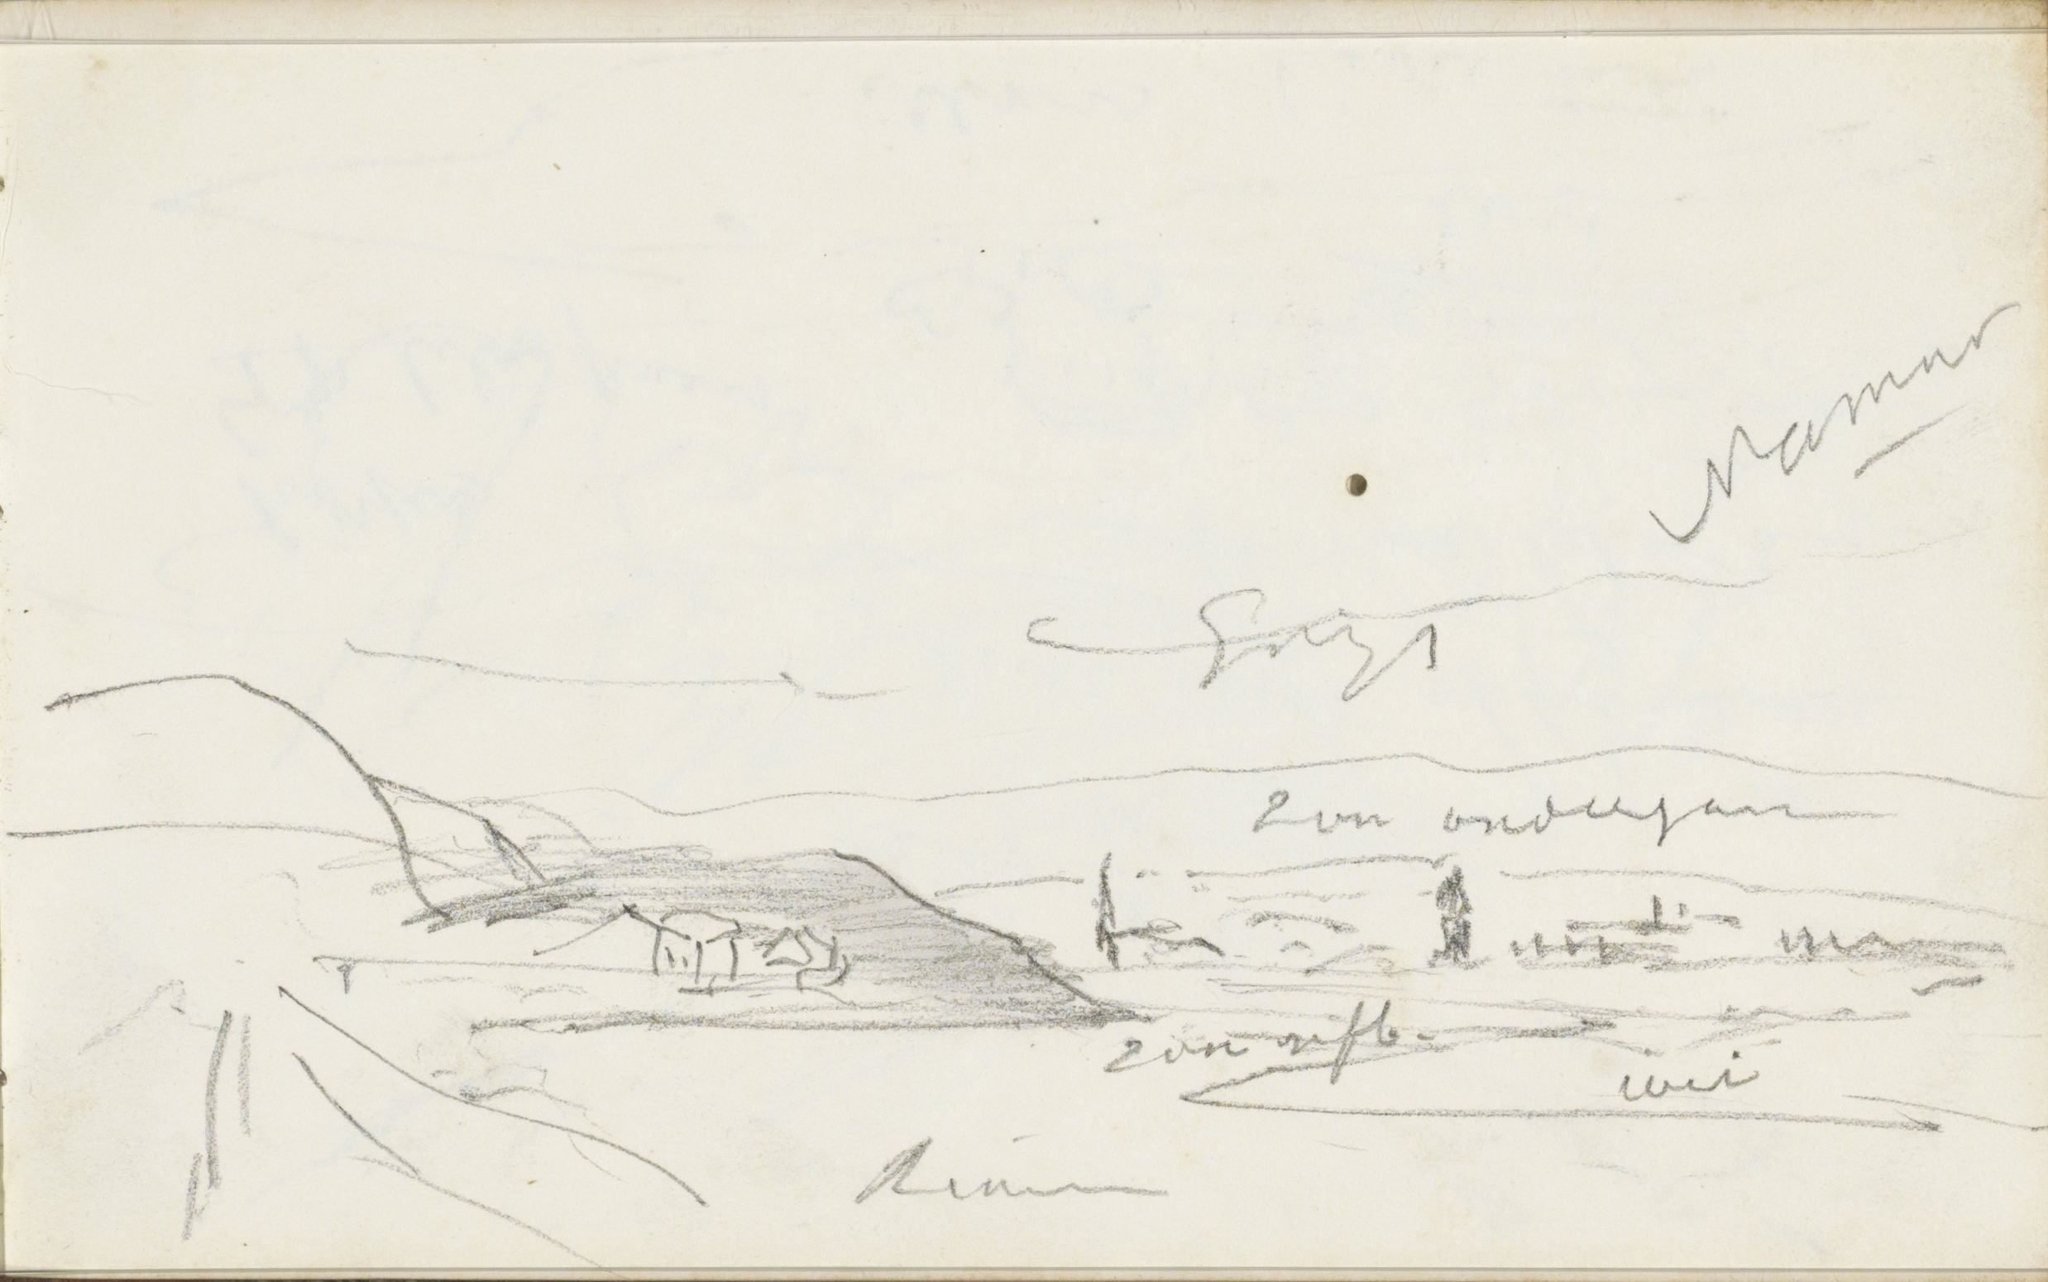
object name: sketchbook leaf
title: Namen aan de Maas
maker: johannes tavenraat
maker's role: draughtsman, painter, print maker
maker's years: 1809-1881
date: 1840-1841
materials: paper, pencil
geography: namur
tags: city-view, and landscape with man-made constructions, landscapes with waters, waterscapes, seascapes (in the temperate zone)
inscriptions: annotation: ‘Namen/ Rivier’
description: Blad 17 recto uit een schetsboek met 41 bladen.